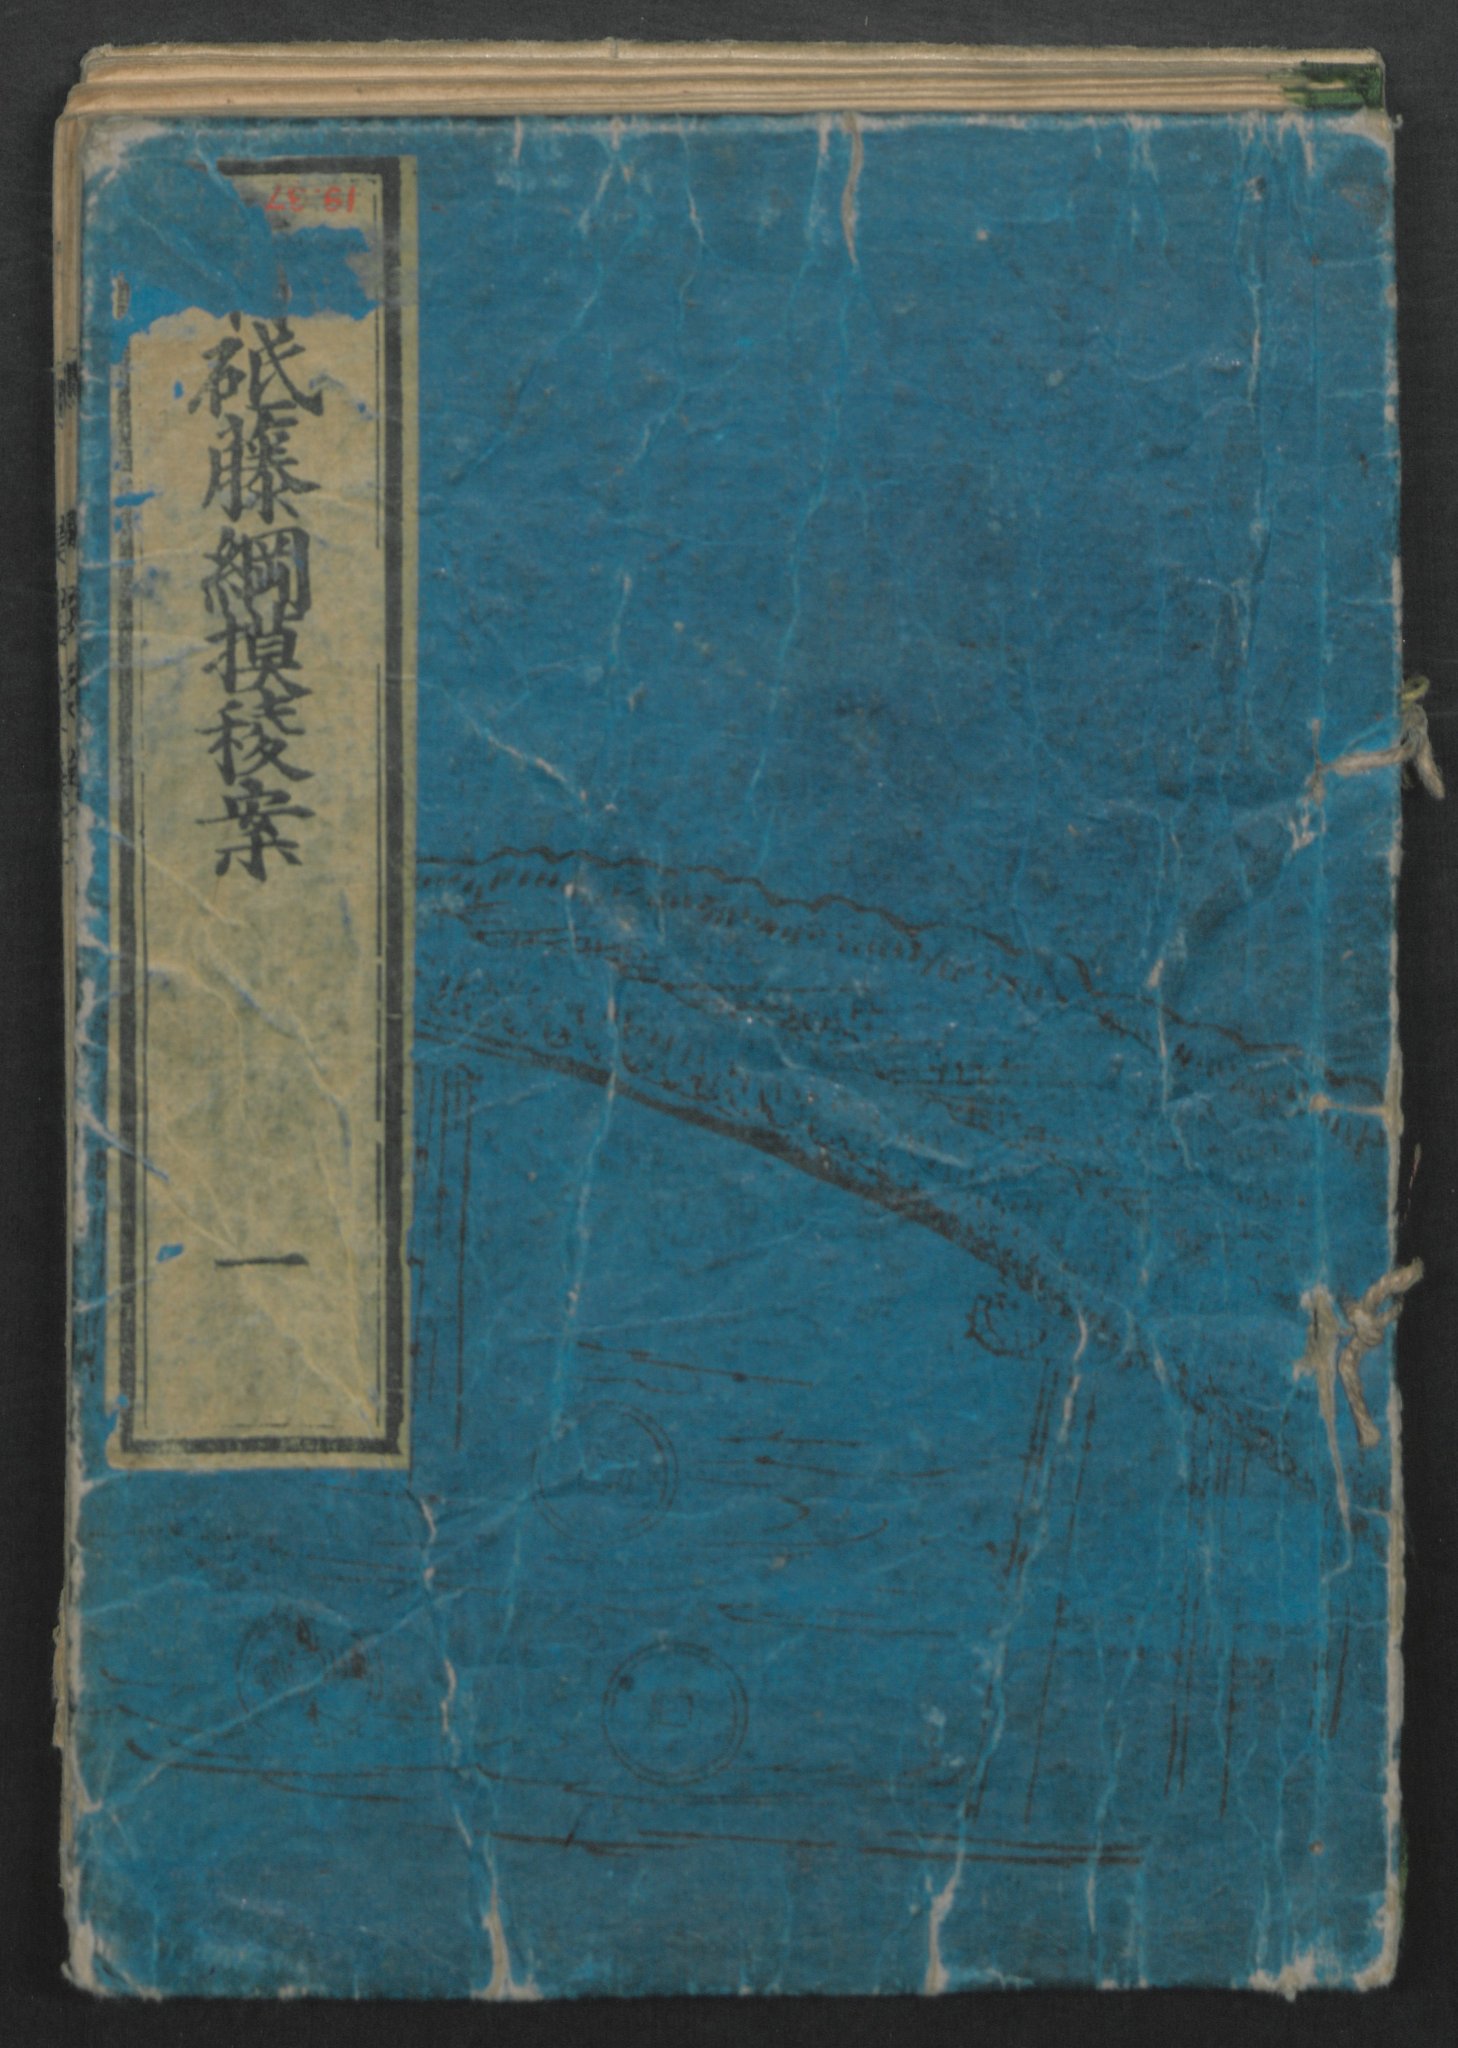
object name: illustrated book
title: The Story of Aoto Fujitsuna (Aoto Fujitsuna moryōan) 青砥藤綱模稜案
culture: japanese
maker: katsushika hokusai 葛飾北斎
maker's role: artist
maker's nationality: japanese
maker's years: 1760-1849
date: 1811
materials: ink, paper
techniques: woodblock print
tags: bridges,men,women